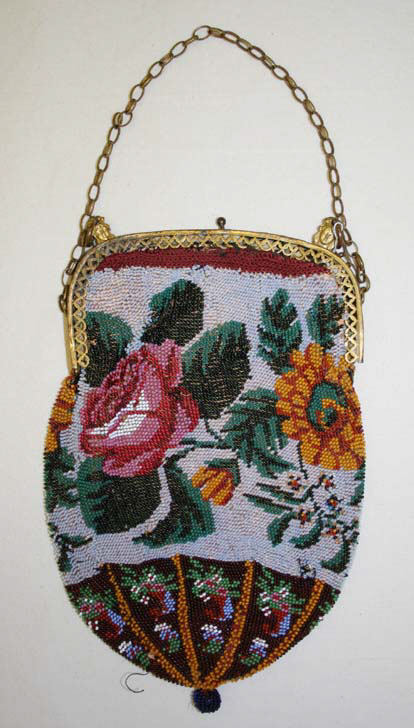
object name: purse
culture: german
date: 1820-1829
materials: glass, metal, wool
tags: roses